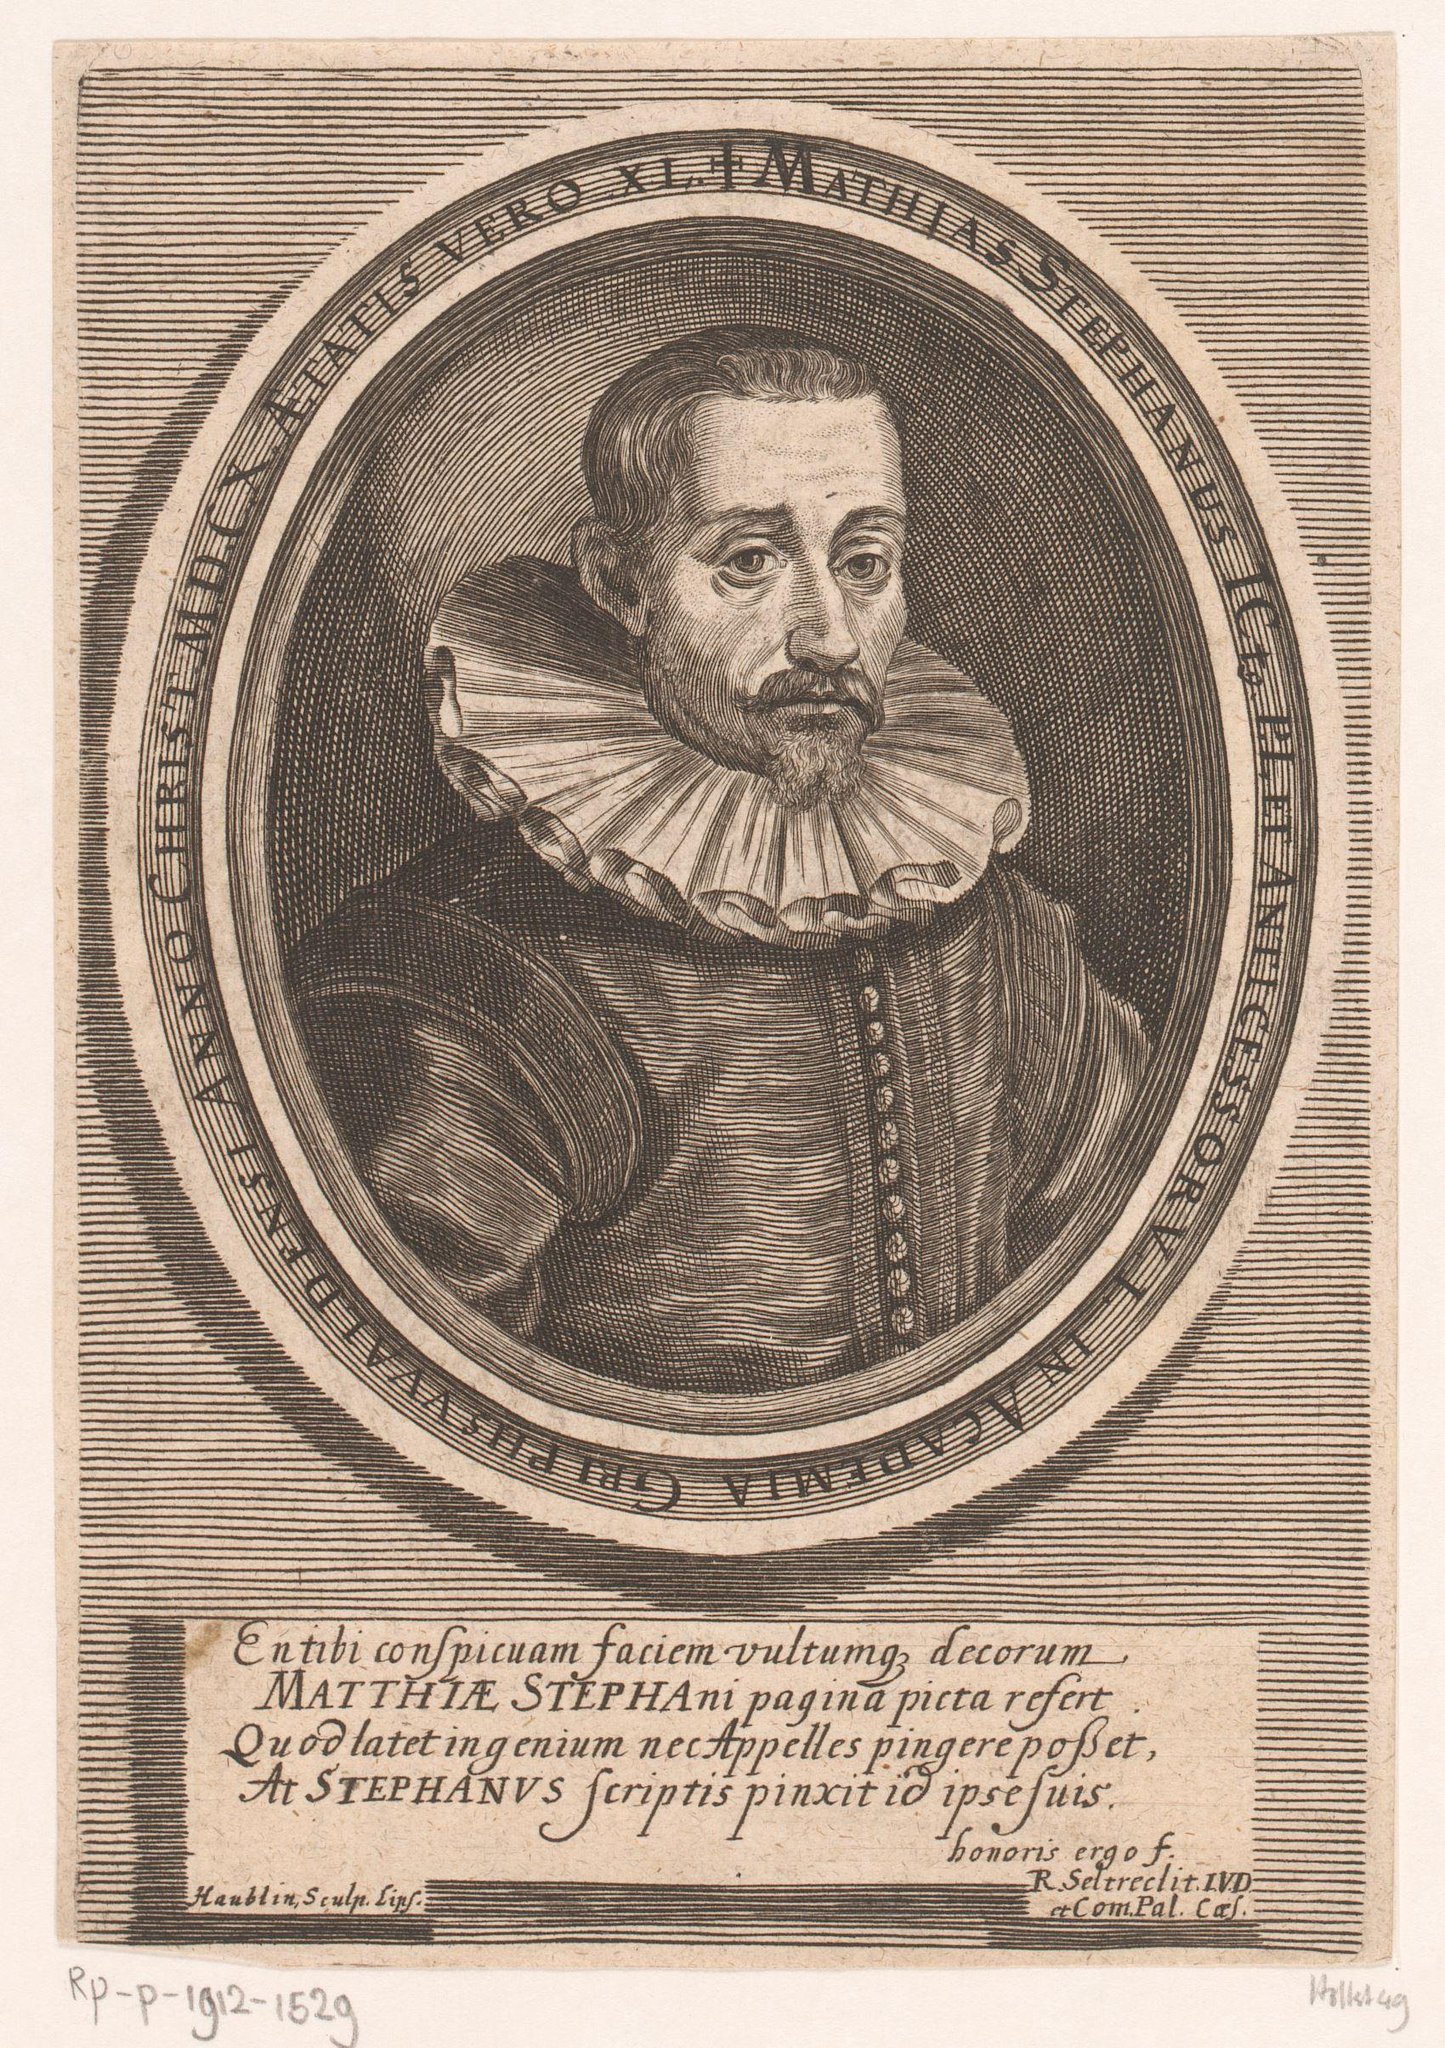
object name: print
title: Portret van Mathias Stephani op 40-jarige leeftijd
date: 1650-1685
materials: paper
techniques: engraving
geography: leipzig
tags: historical persons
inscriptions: collector's mark: Lugt 2228